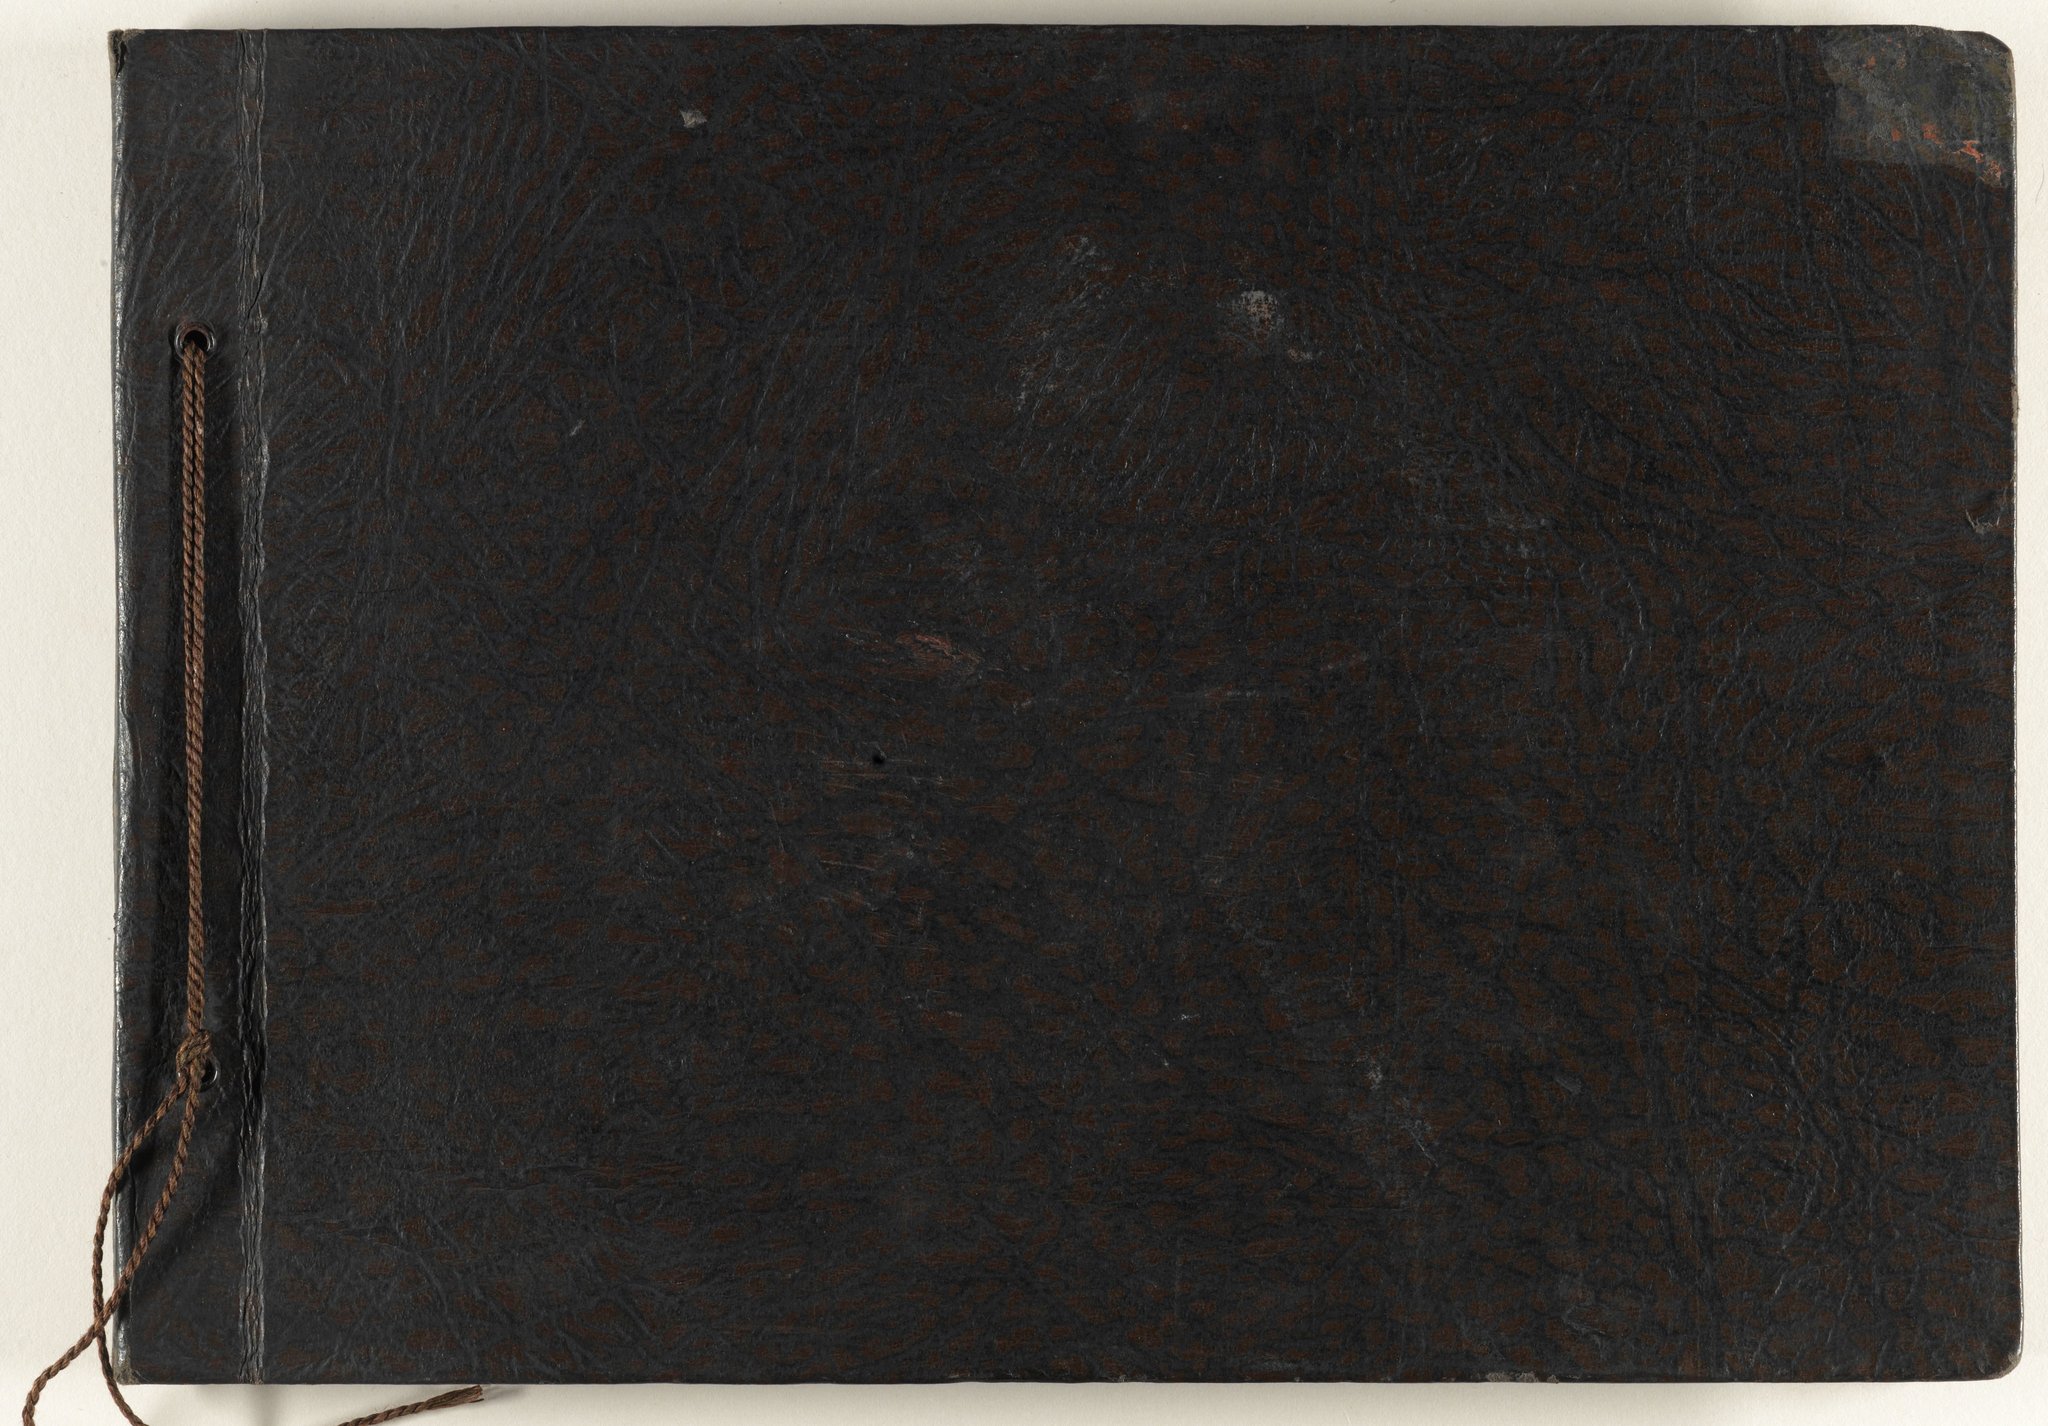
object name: scrapbook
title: Fotoalbum met 25 foto's van winkelinterieurs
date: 1925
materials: paper, cardboard, leather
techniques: gelatin silver print, writing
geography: netherlands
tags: confectioner, counter ~ shop, butcher, slaughterman, leiden, groningen (province), the hague, den helder, haarlem, amsterdam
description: Fotoalbum met 25 foto's verdeeld over 24 pagina's. De eerste foto ligt los in het album. Alle foto's betreffen winkelinterieurs van onder meer slagerijen, kruidenierszaken, bakkers en drogisterijen. De winkels bevinden zich door heel Nederland, al komt Amsterdam meer voor dan andere steden. Elke foto heeft handgeschreven bijschriften van de naam van de winkel, adres en de stad. Van alle foto's is de maker anoniem, op de eerste foto na. Uit het artikel 'De verdiensten van een kassa' van Fleur Roos Rosa de Carvalho blijkt dat dit een presentatiealbum is, gemaakt in opdracht van de National Cash Register, de fabrikant van kassa's die in de gefotografeerde winkels op de toonbank staat.